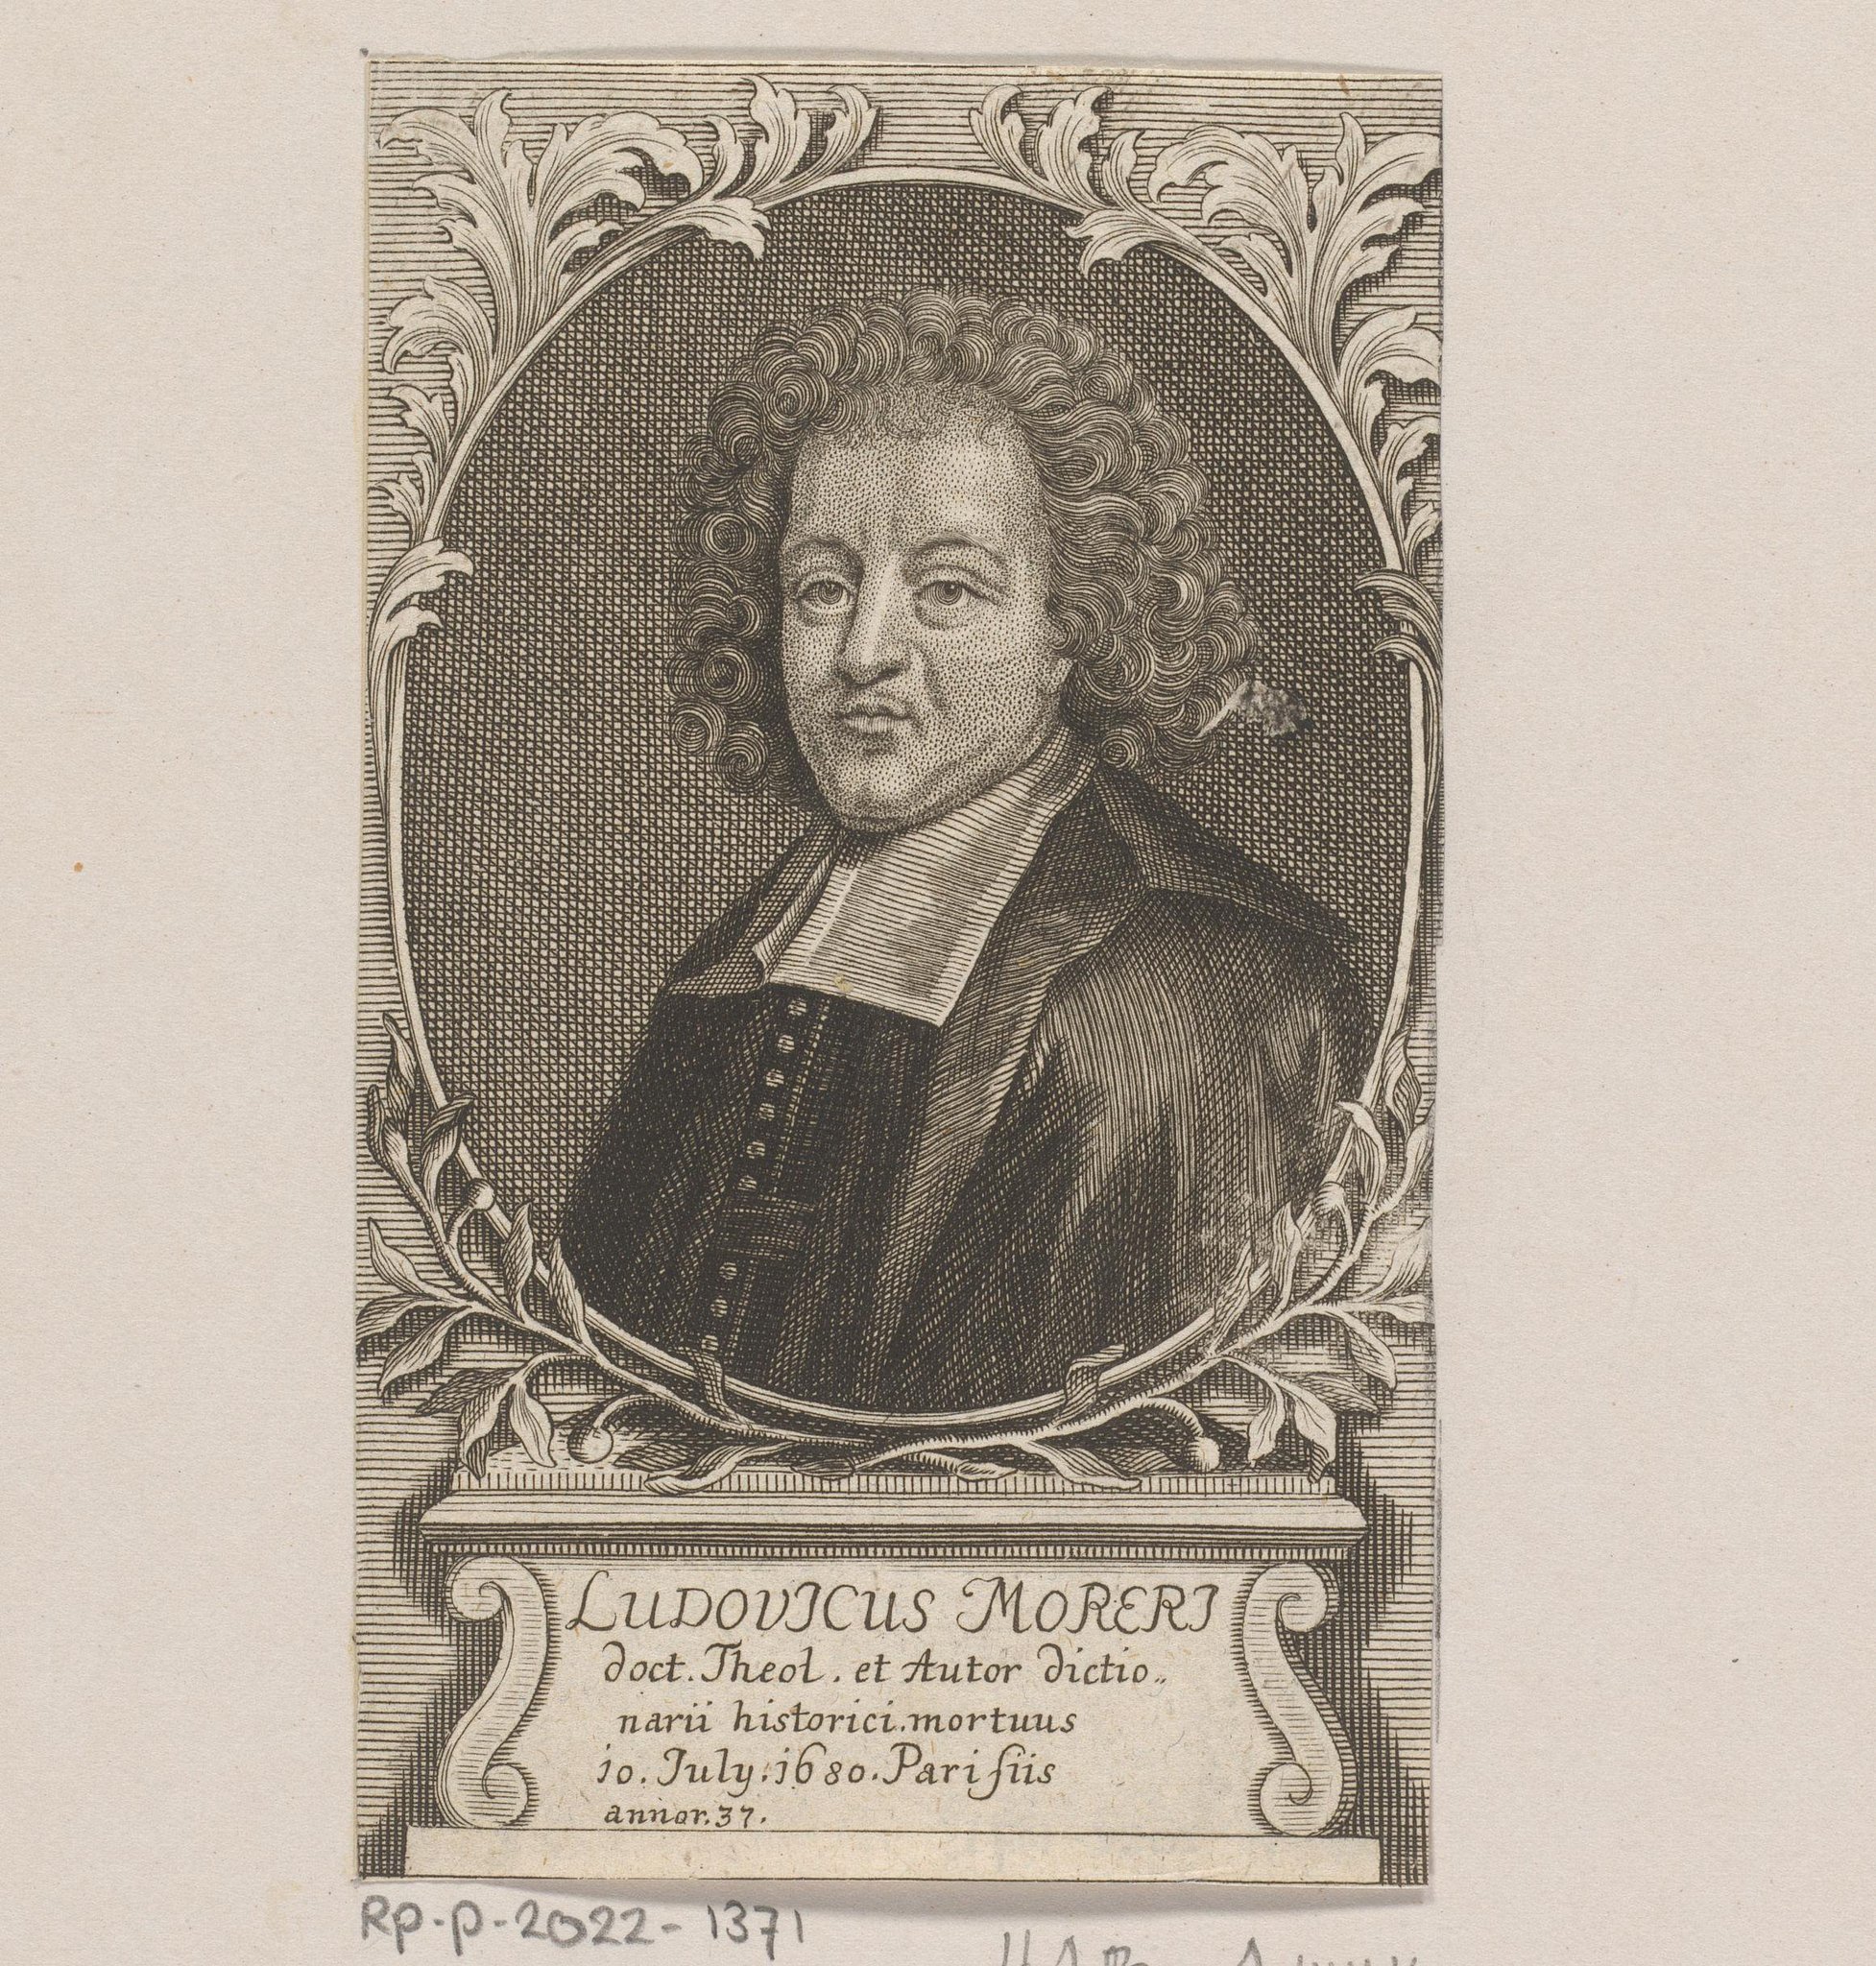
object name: book illustration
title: Ludovicus Moreri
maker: Anonymous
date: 1713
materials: paper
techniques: engraving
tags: hierarchy of jurisdiction ~ roman catholic church, historical persons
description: Prent waarschijnlijk uit: Neuer Bücher-Saal der Gelehrten Welt (...). Leipzig: Johann Ludwig Gleditsch en Moritz Georg Weidmann, 1713.